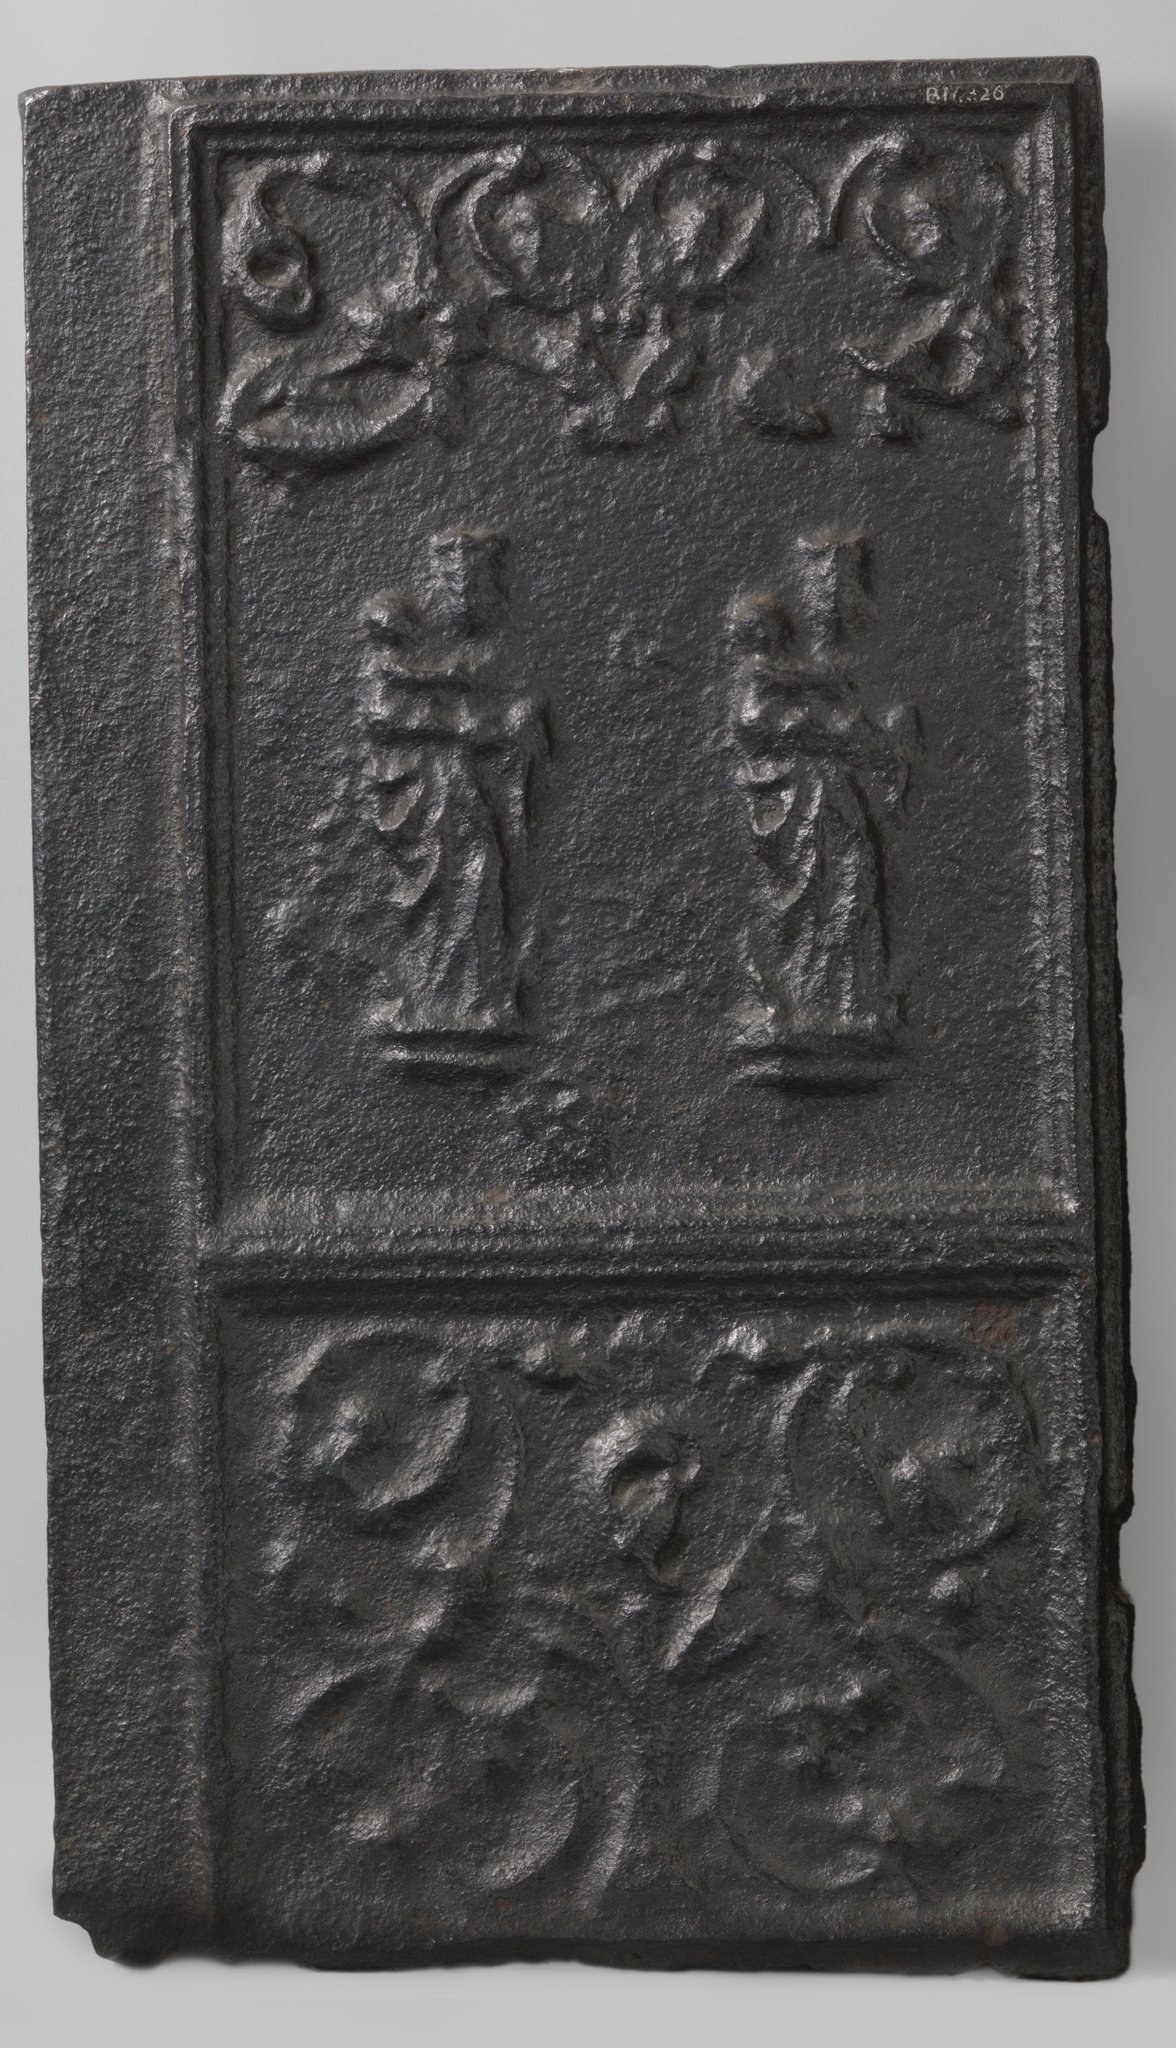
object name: stove plate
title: Kachelplaat met tweemaal Maria met kind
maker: Anonymous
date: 1525-1575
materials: iron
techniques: casting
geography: germany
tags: madonna: mary standing (or half-length), christ-child close to her bosom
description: Kachelplaat van gietijzer, verdeeld in twee zones. In de bovenste zone tweemaal een voorstelling van Maria met kind, staande op een cul-de-lampe, waarboven rankornament. In de onderste zone een vaas met ranken. De plaat is gedeeltelijk ingemetseld geweest.